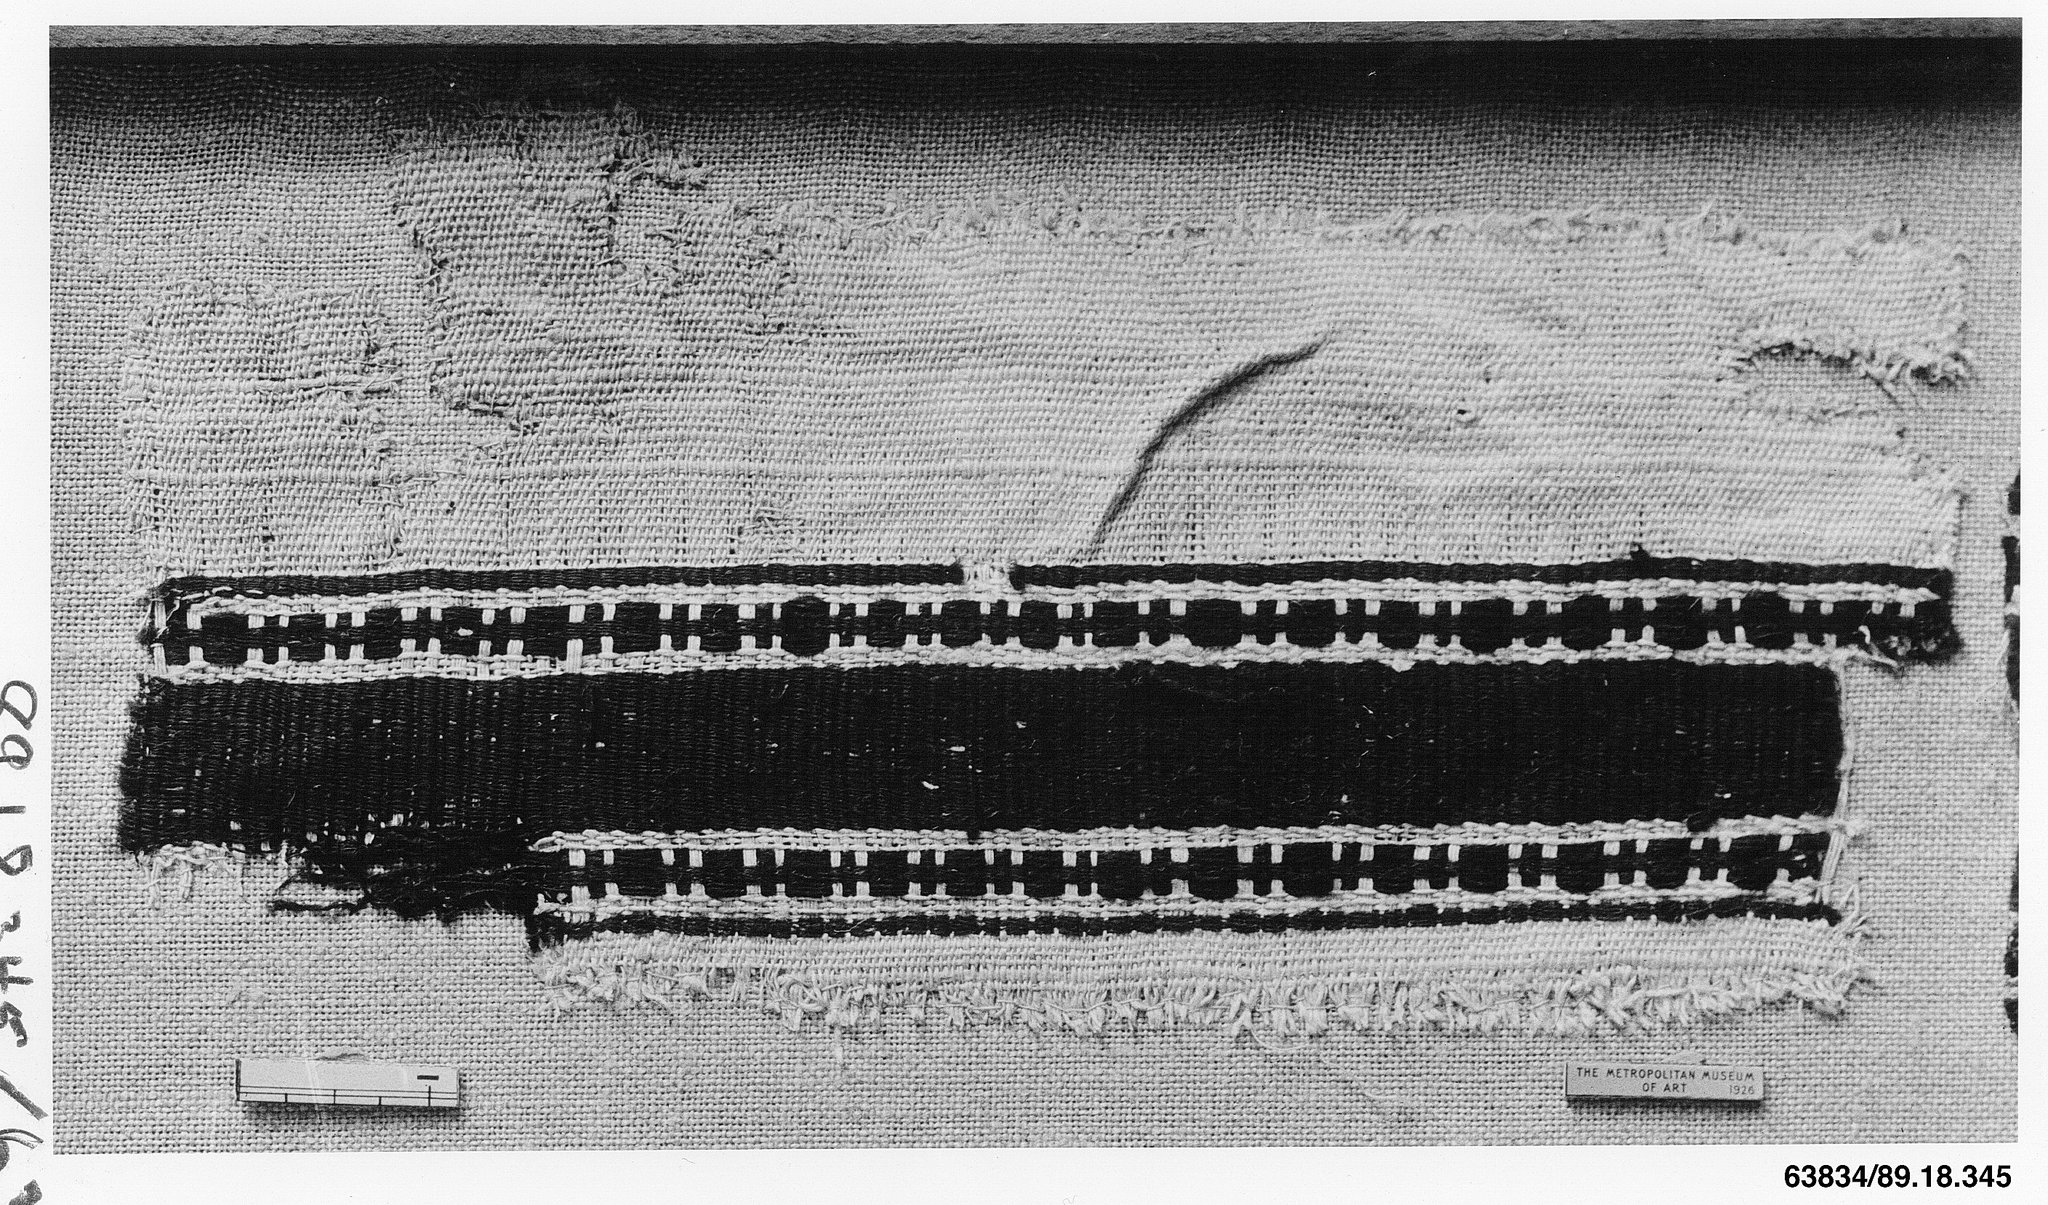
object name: textile fragment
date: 201-400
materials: linen, wool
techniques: weave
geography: egypt